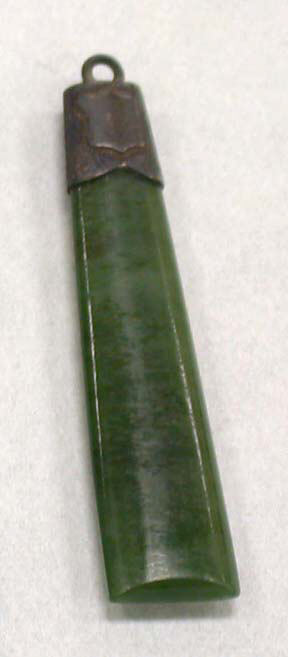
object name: pendant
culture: new zealander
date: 1801-1900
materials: jade